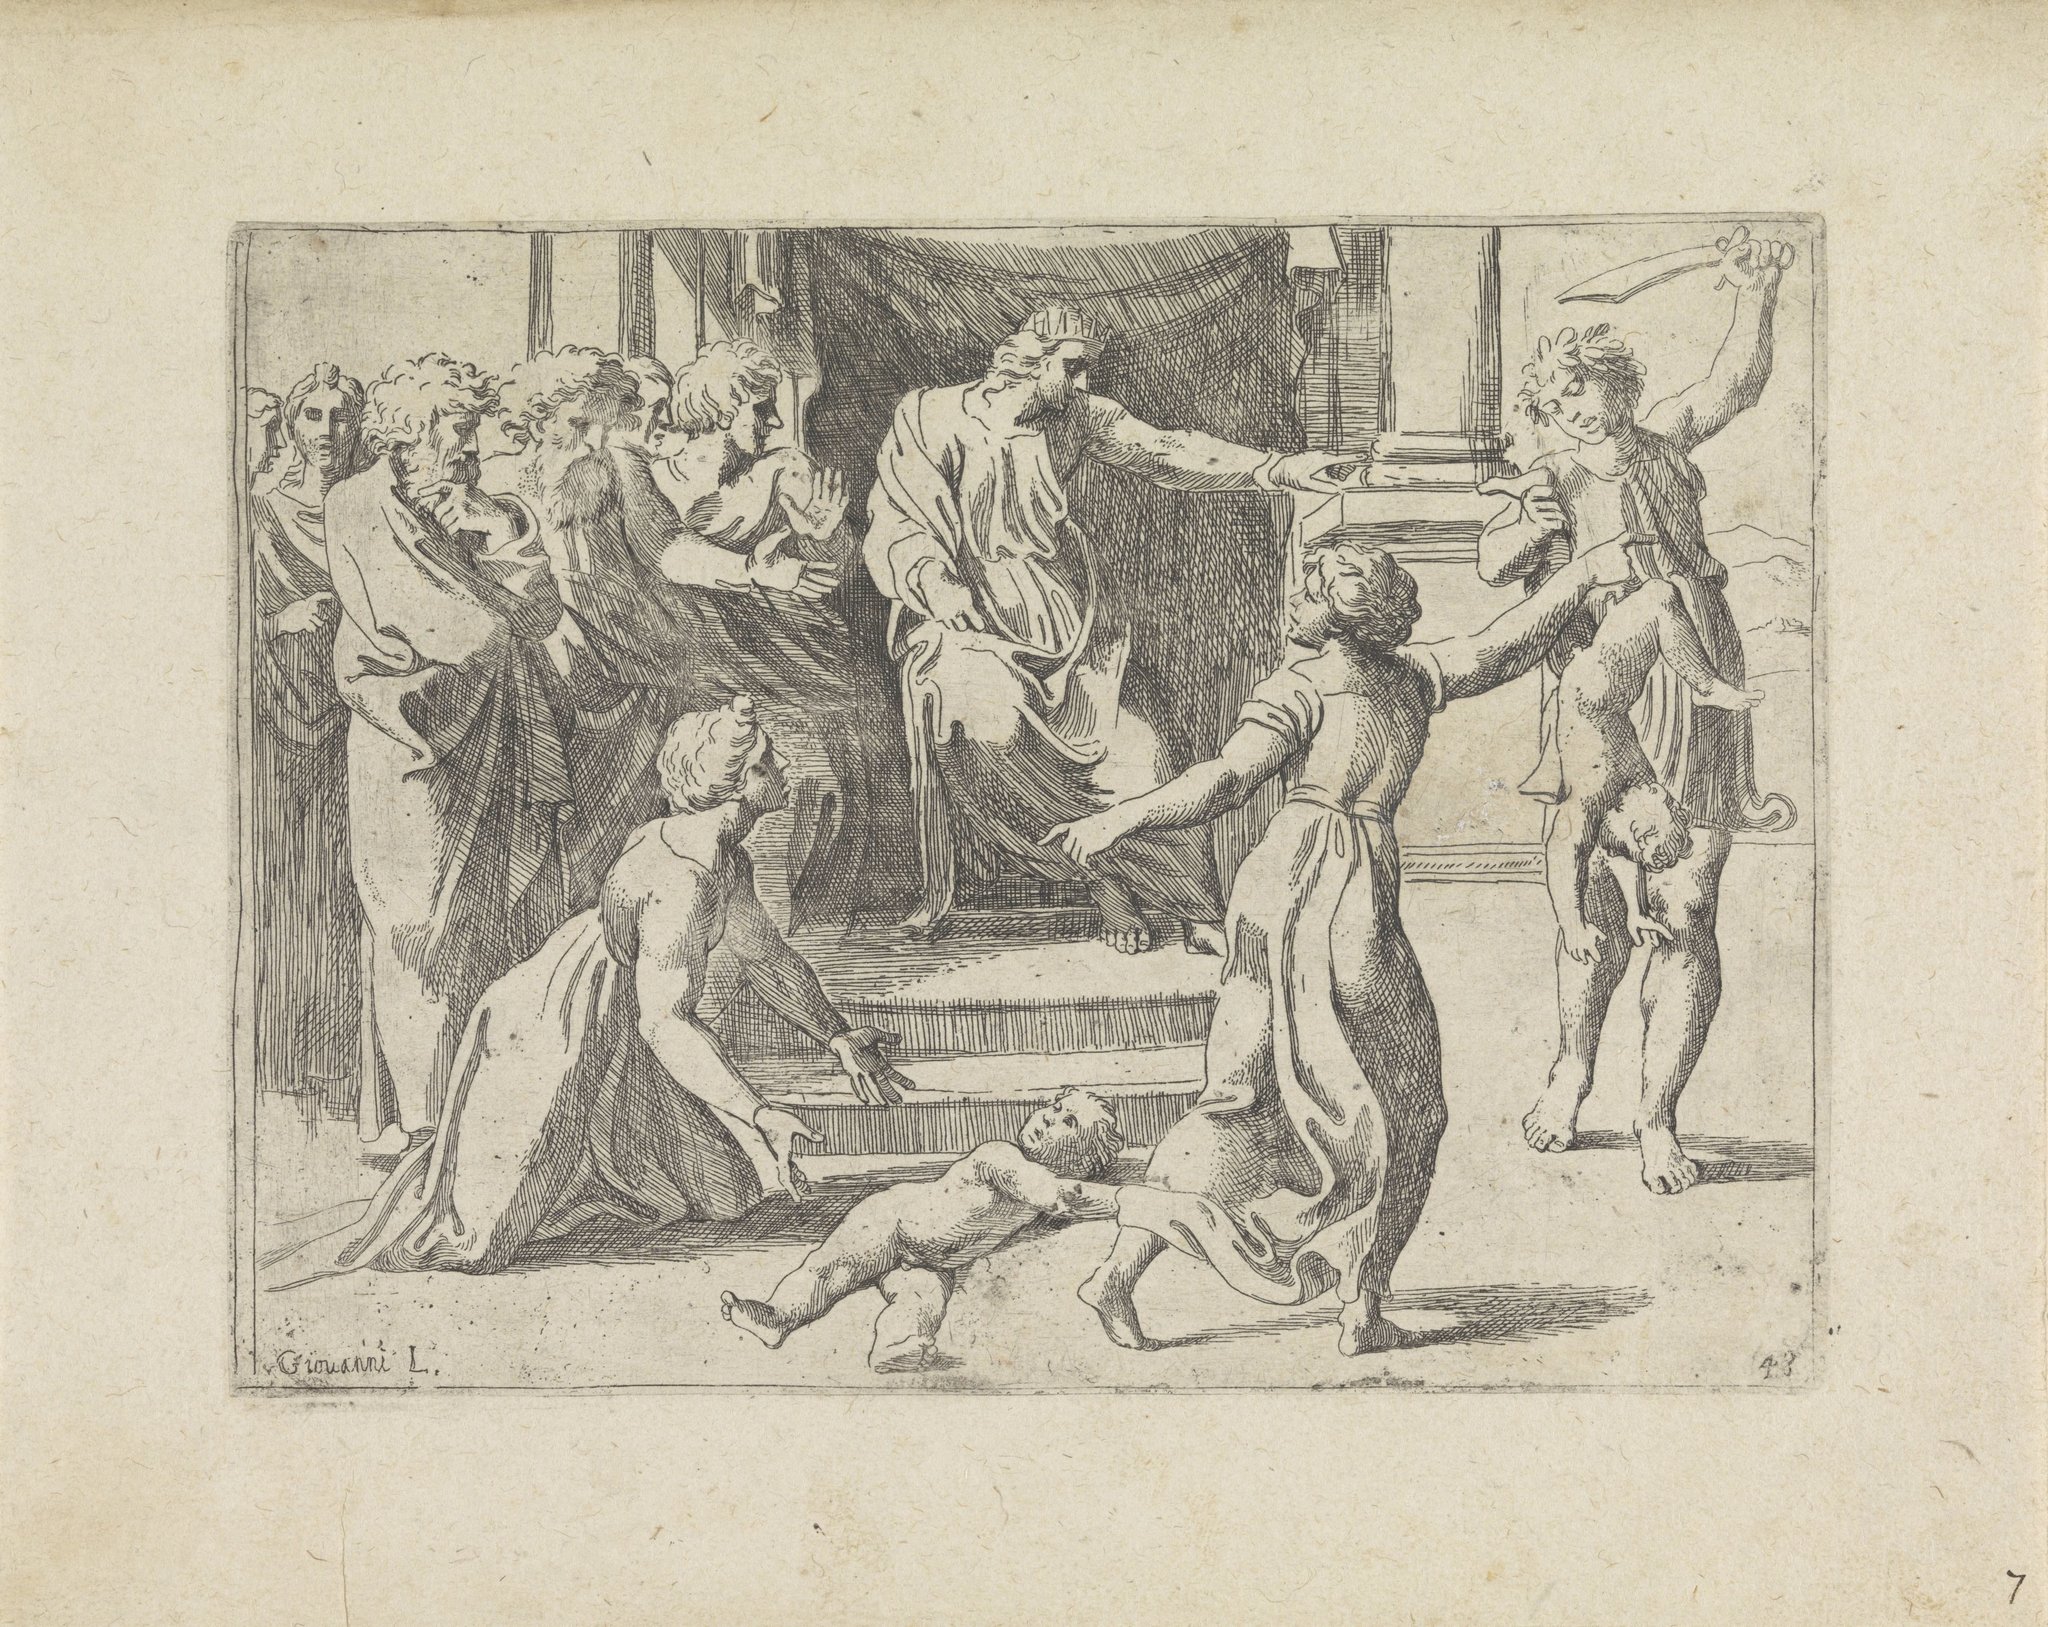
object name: print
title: Oordeel van Salomo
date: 1607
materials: paper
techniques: etching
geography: italy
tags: the judgement of solomon (1 kings 3:16-28)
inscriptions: number: ‘7’, collector's mark: ‘Hinloopen’, collector's mark: Lugt 11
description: Koning Salomo zit op zijn troon en velt een oordeel over een geschil tussen twee prostituees die beiden een kind hadden gekregen. Het kind dat dood gaat ligt op de grond voor Salomo, het kind dat nog leeft en door beide moeders wordt opgeëist, wordt vastgehouden door een man met een zwaard. Deze man krijgt van Salomo de opdracht het kind in tweeën te delen maar dit gaat de echte moeder te ver, zij smeekt hem haar kind te laten leven.